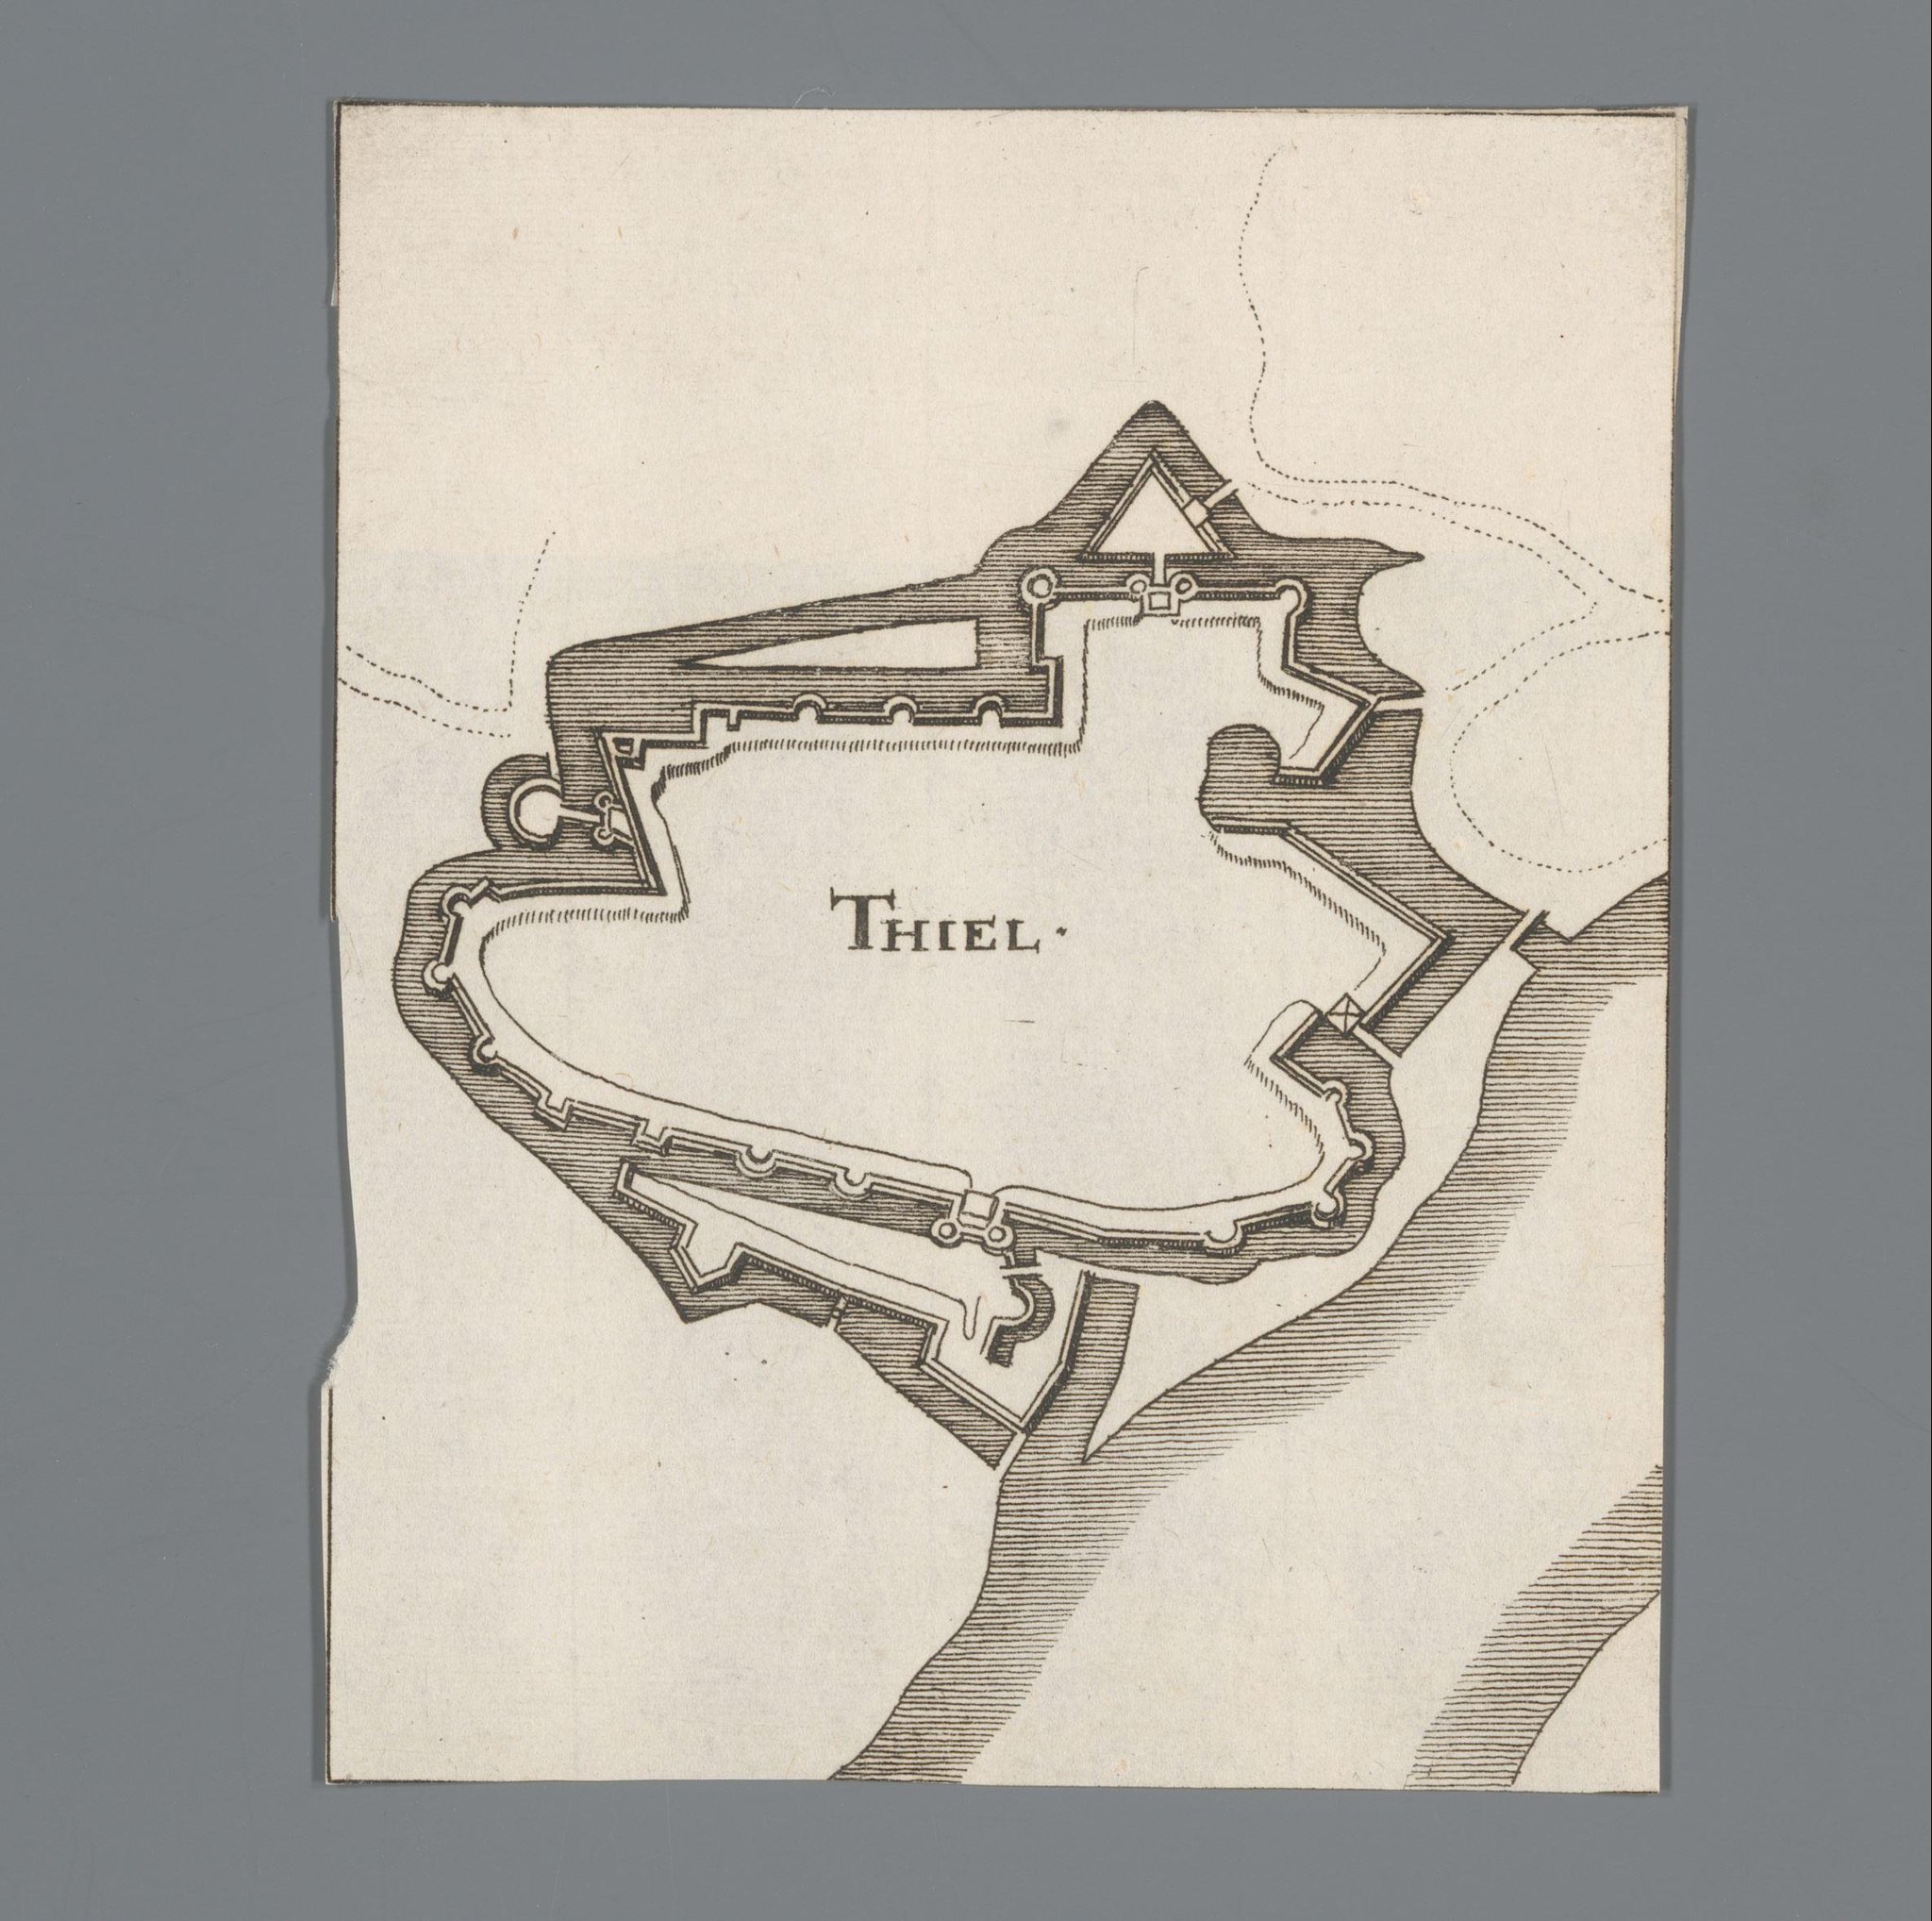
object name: print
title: Vestingplattegrond van Tiel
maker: Anonymous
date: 1670-1730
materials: paper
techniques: etching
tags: fortified city, maps of cities